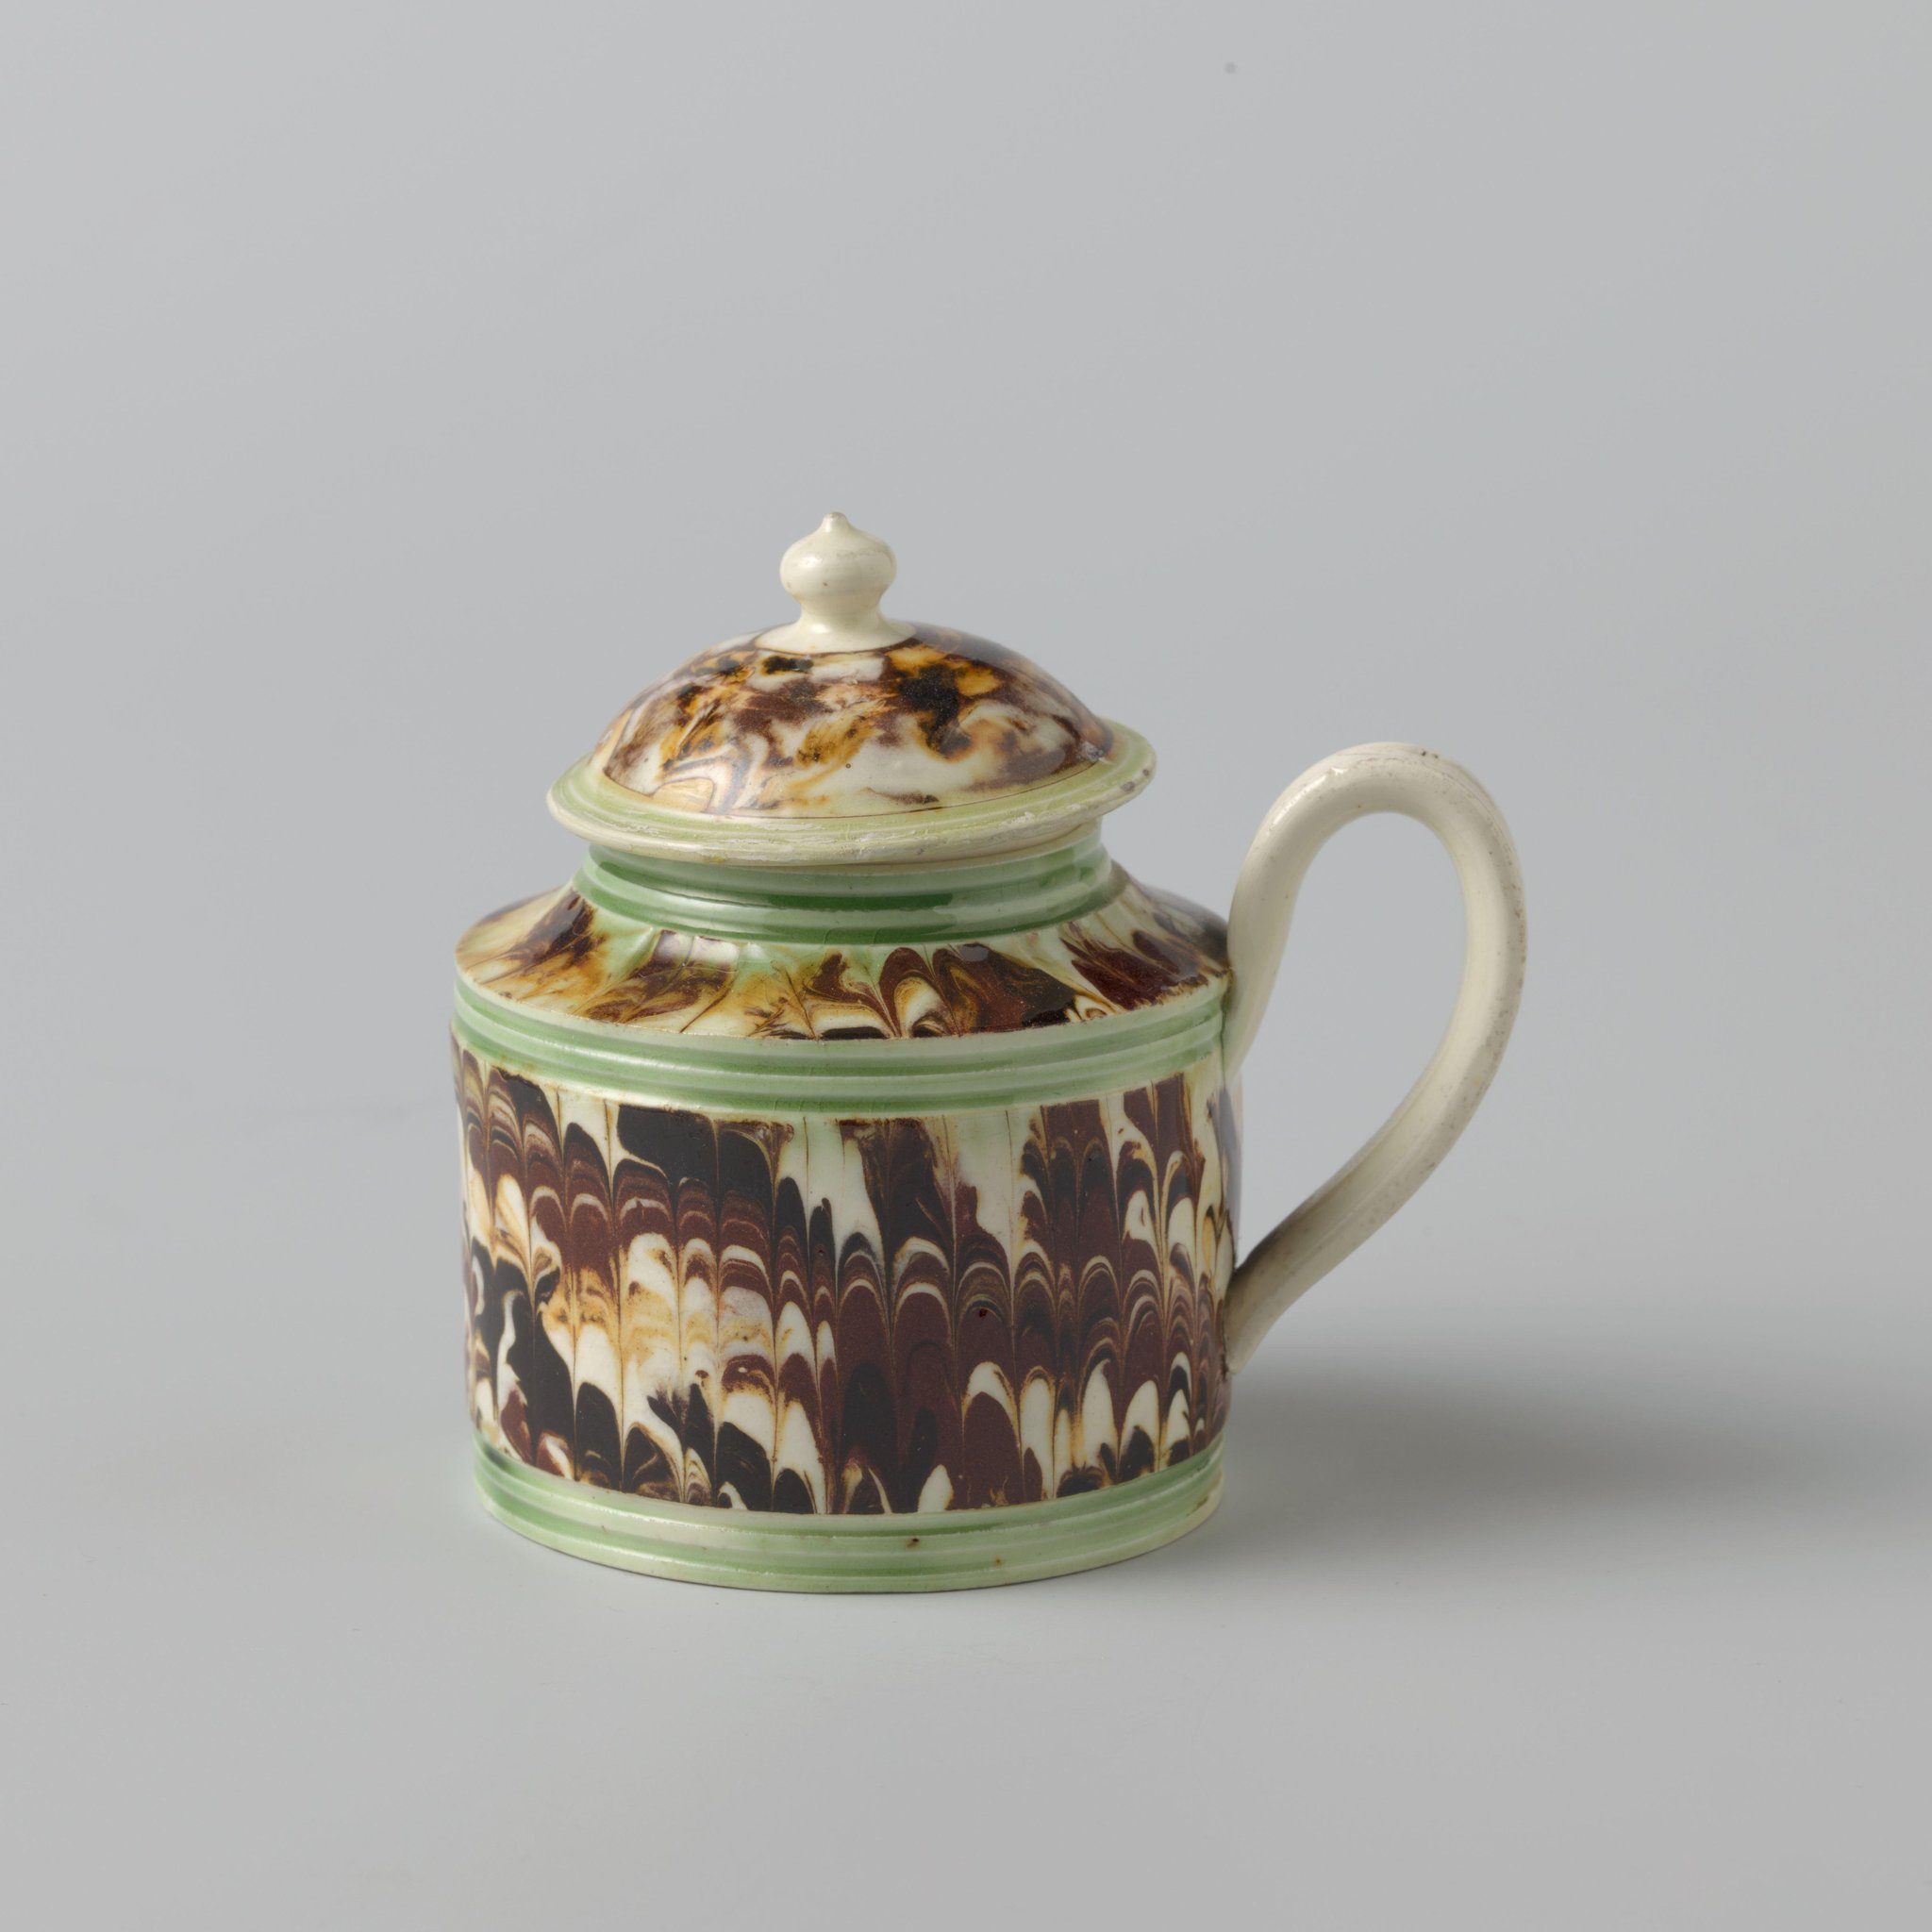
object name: roompot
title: Mosterdpot of roompot van hardgebakken aardewerk, creamware met gemarmerde decoratie.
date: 1778-1786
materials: earthenware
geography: staffordshire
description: Cilindrische mosterdpot of roompot van hardgebakken aardewerk. De pot heeft een smalle, lage hals en een C-vormig oor. De pot heeft een gemarmerde decoratie in geel, bruin en zwart.